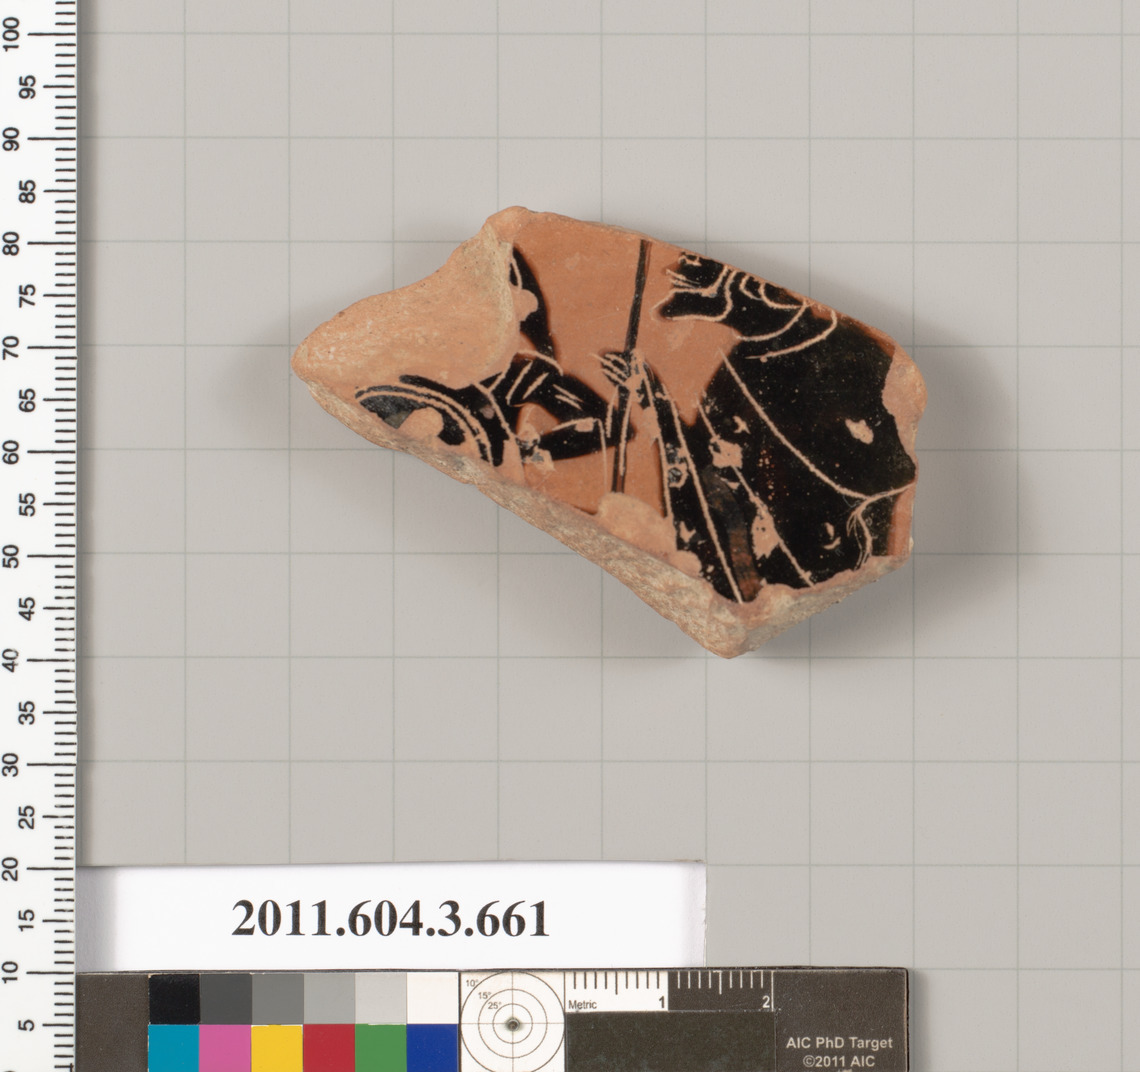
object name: volute krater fragment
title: Terracotta fragment of a volute-krater (bowl for mixing wine and water)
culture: greek, attic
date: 534-501 BCE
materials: terracotta